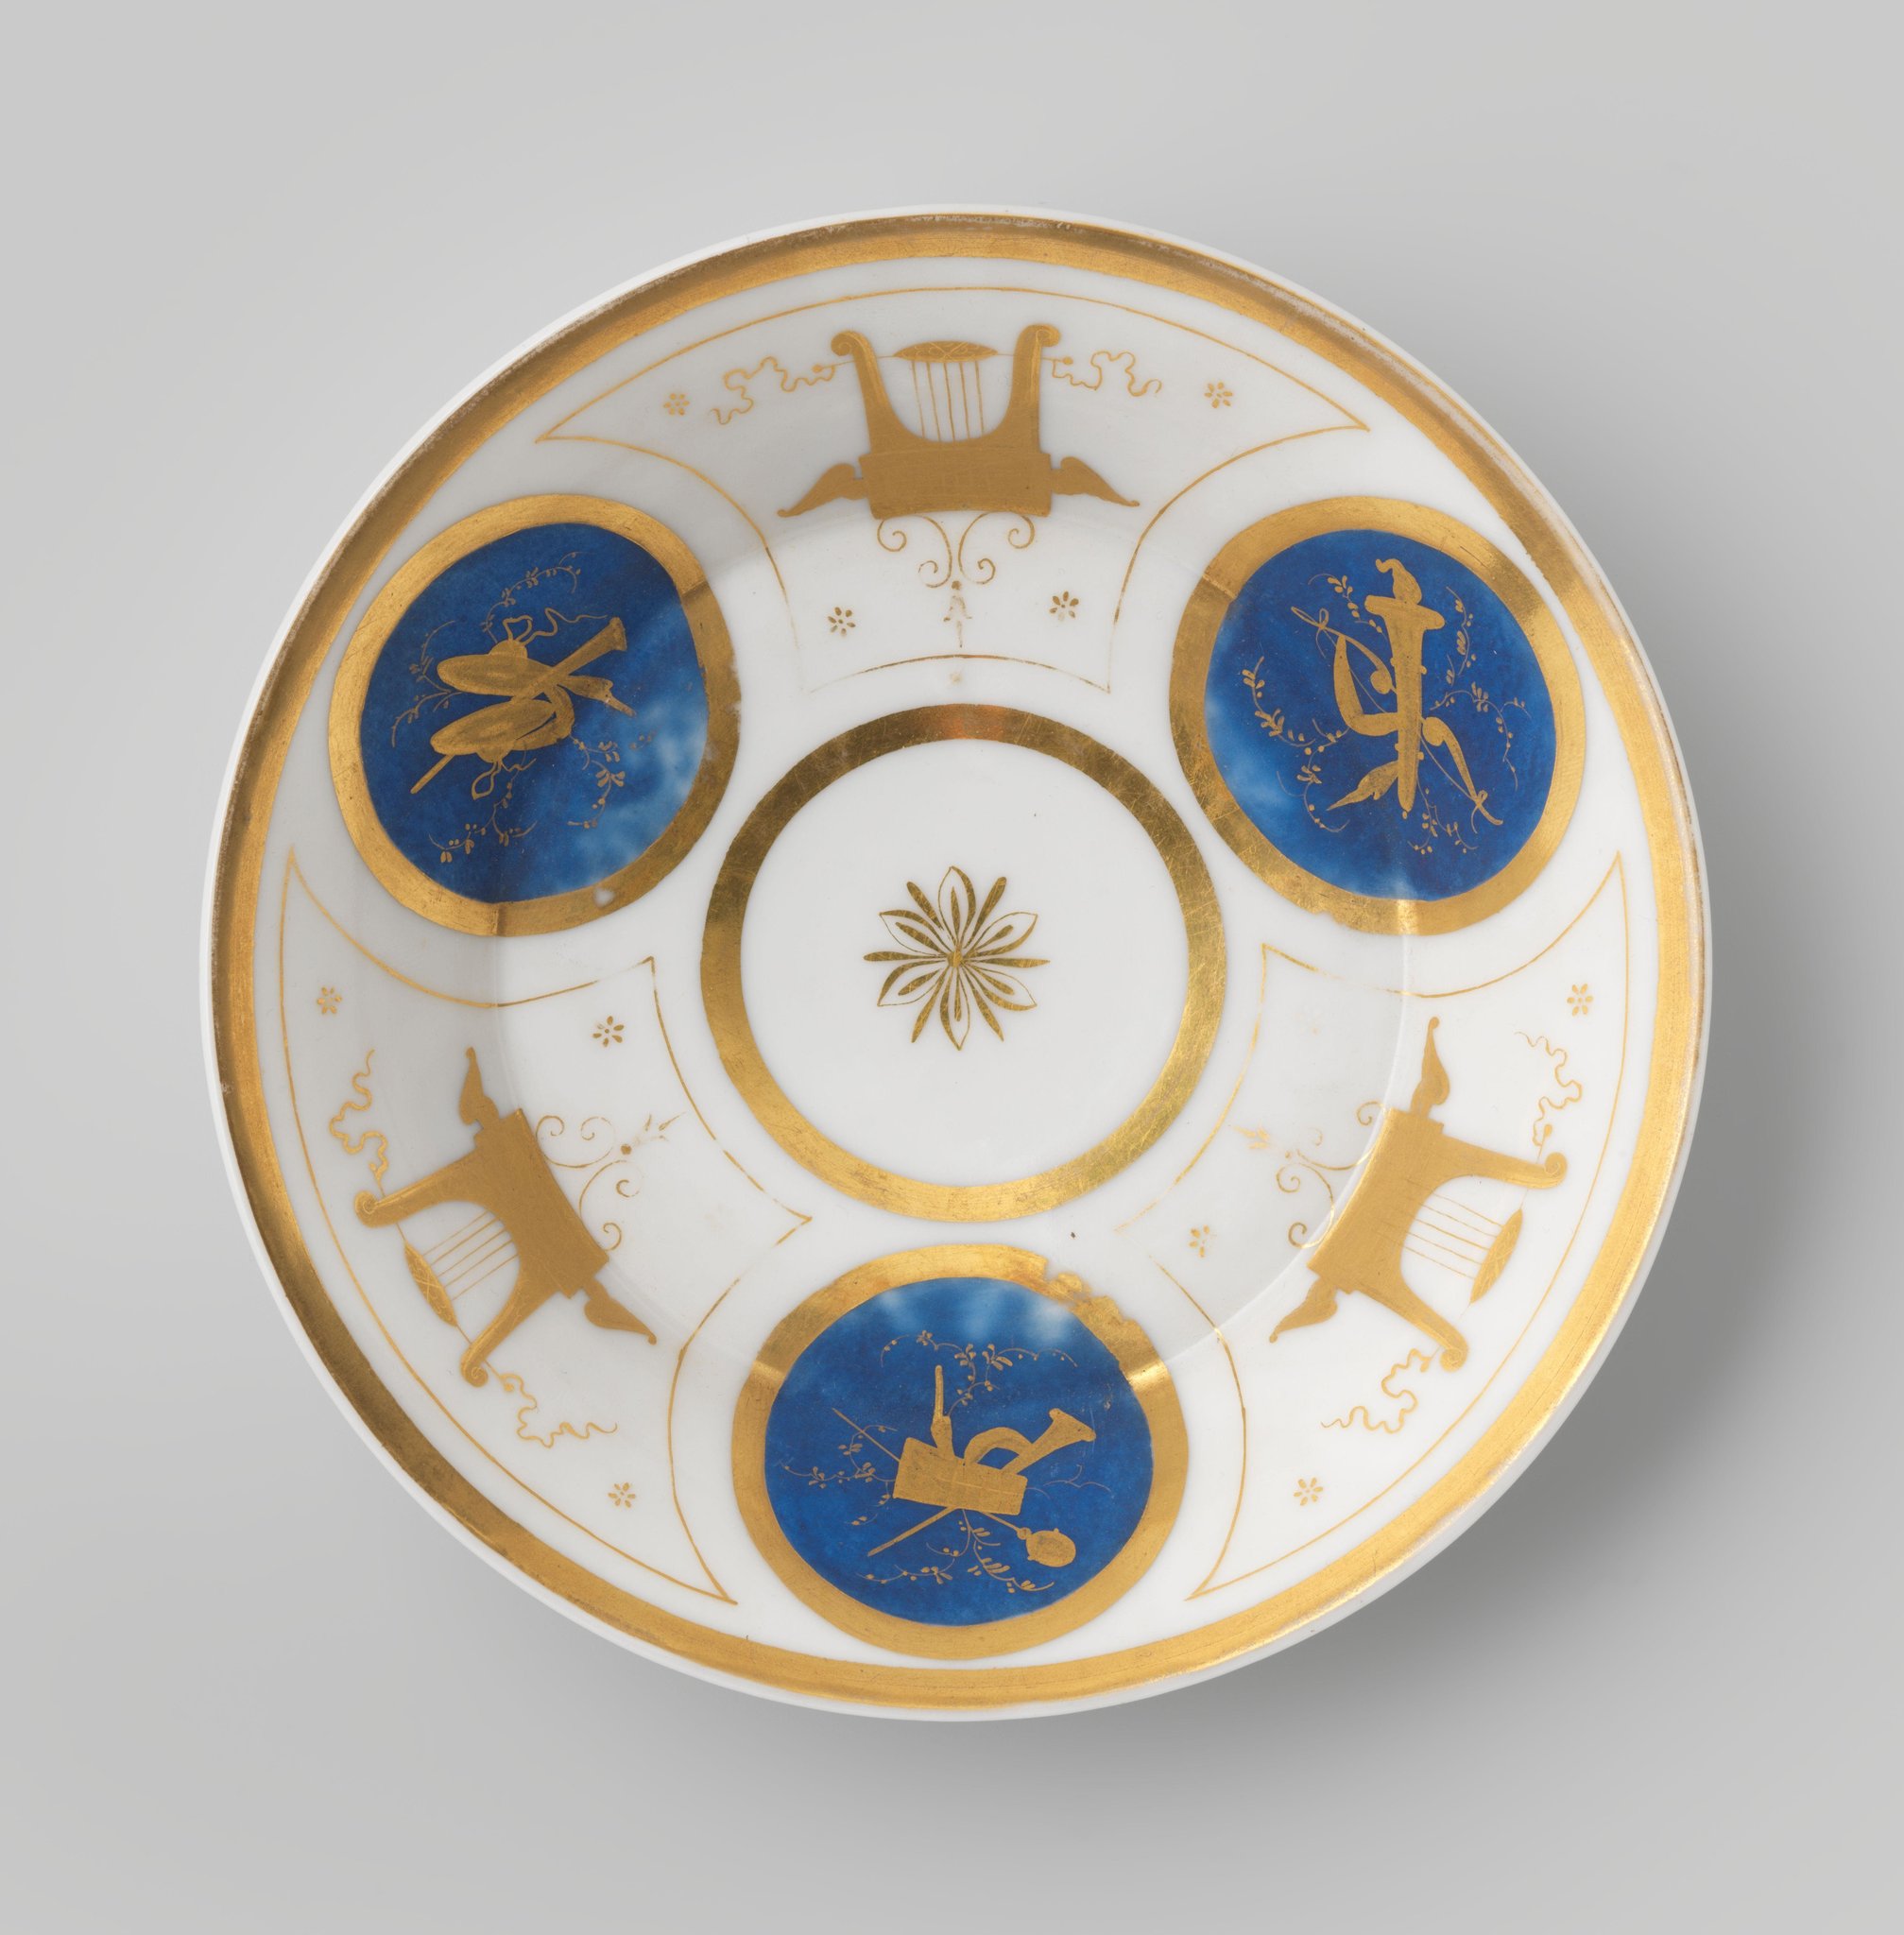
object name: platter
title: Saucer with musical instruments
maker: Anonymous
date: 1790-1800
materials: glaze, gold, paint, porcelain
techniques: firing, forming, gilding, relief, turning, vitrification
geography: france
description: Schotel van porselein met een rechte wand, beschilderd op het glazuur in blauw en goud. Op het plat een rozet in een medaillon. Om dit medaillon, doorlopend op de wand afwisselend waaiervormige vakken met een harp en gouden medaillons met muziekinstrumenten tegen een matblauwe achtergrond. Gouden band op de rand.